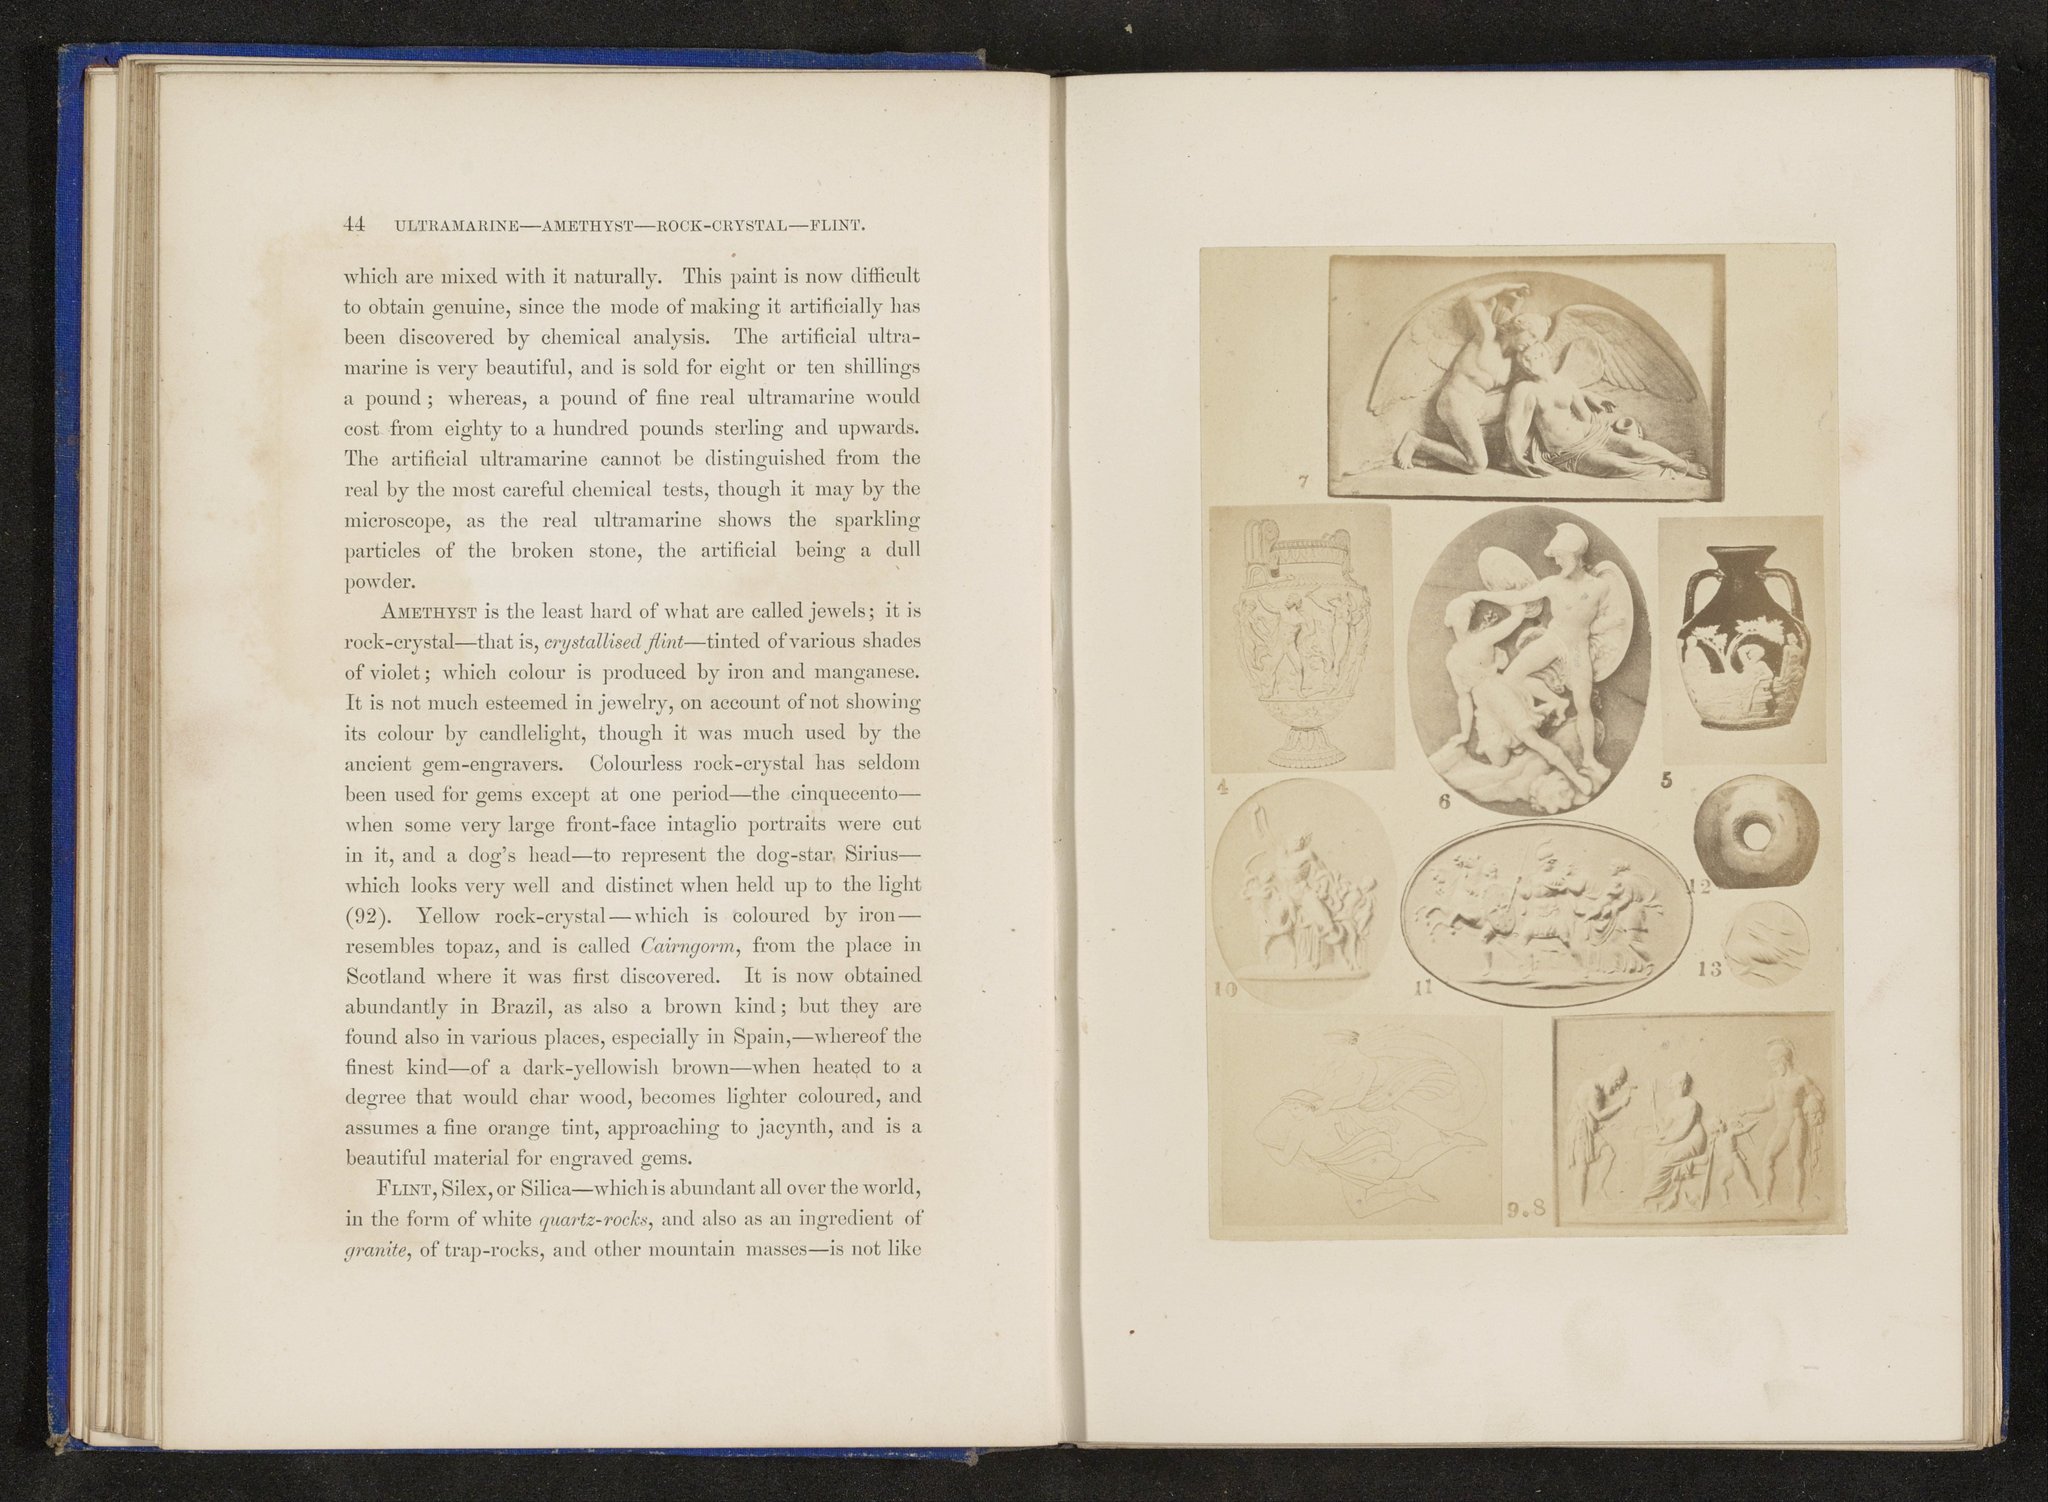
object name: photograph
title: Tien reliëfs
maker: f. cole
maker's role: fotograaf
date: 1857-1867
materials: photographic support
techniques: albumen print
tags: vase ~ ornament, man (showing himself) undressed, quasi-nude, sculpture (+ relief ~ sculpture)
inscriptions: number: ‘4 - 13’